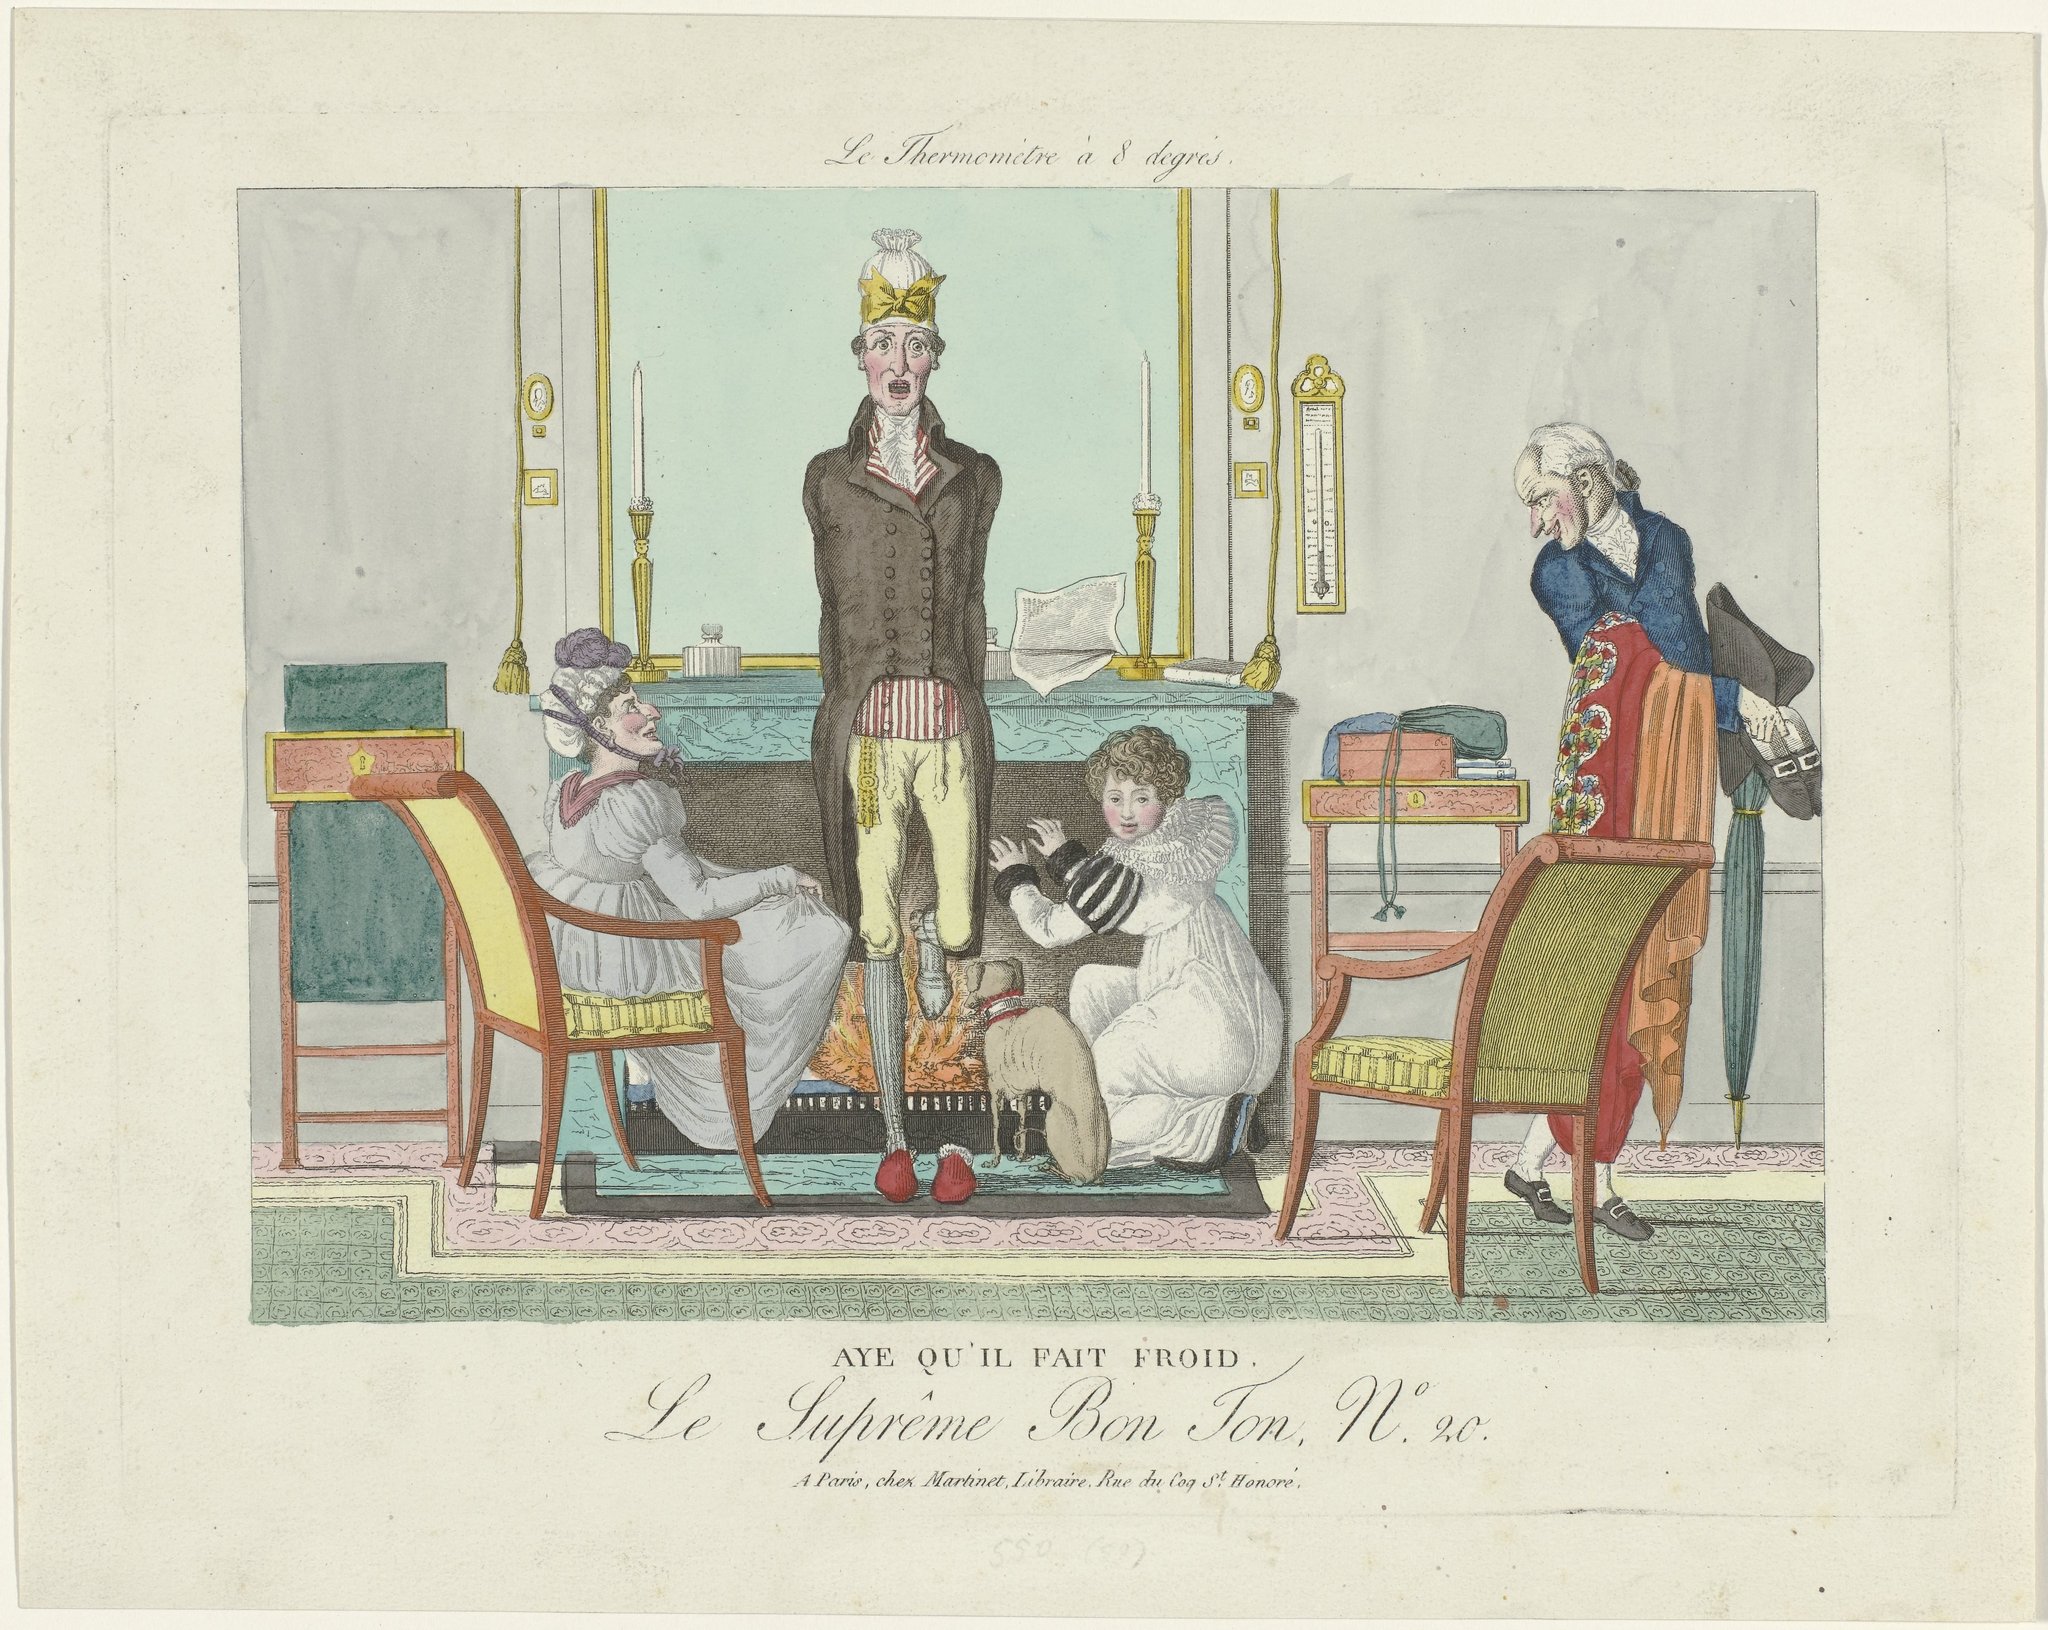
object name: fashion print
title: Le Supreme Bon Ton, Le Thermomètre à 8 degrés, 1800-1815, No. 20: Aye qu'il fait froid.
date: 1800-1815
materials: paper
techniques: etching, hand coloring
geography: paris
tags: clothing for the upper part of the body (vest) (+ men's clothes), coldness, coat (frac) (+ men's clothes), warming oneself at a fire (or hearth, stove, fire-pan, brazier), head-gear: cap (+ men's clothes), fashion plates, head-gear: hat (+ women's clothes), dress, gown (+ women's clothes), trousers, breeches, etc. (breeches) (+ men's clothes), stockings, socks (+ men's clothes), thermometer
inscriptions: caption: ‘AYE QU'IL FAIT FROID.’, title: ‘Le Suprême Bon Ton, No. 20.’, address: ‘A Paris, chez Martinet, Libraire, Rue du Coq S.t Honoré.’, title: ‘Le Thermomètre à 8 degrés.’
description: Een gezelschap warmt zich bij een open haard. Een man staat met zijn rug naar het vuur en heeft één voet opgetild. Naast hem zit een oudere vrouw, een geknield meisje en een hond. Een bediende kijkt glimlachend naar ze om terwijl hij enkele kledingstukken in de handen heeft. Volgens de thermometer (en het onderschrift) is het erg koud in het vertrek. Prent uit een serie van 30 modeprenten, Le Suprême Bon Ton, Parijs, 1800-1815.